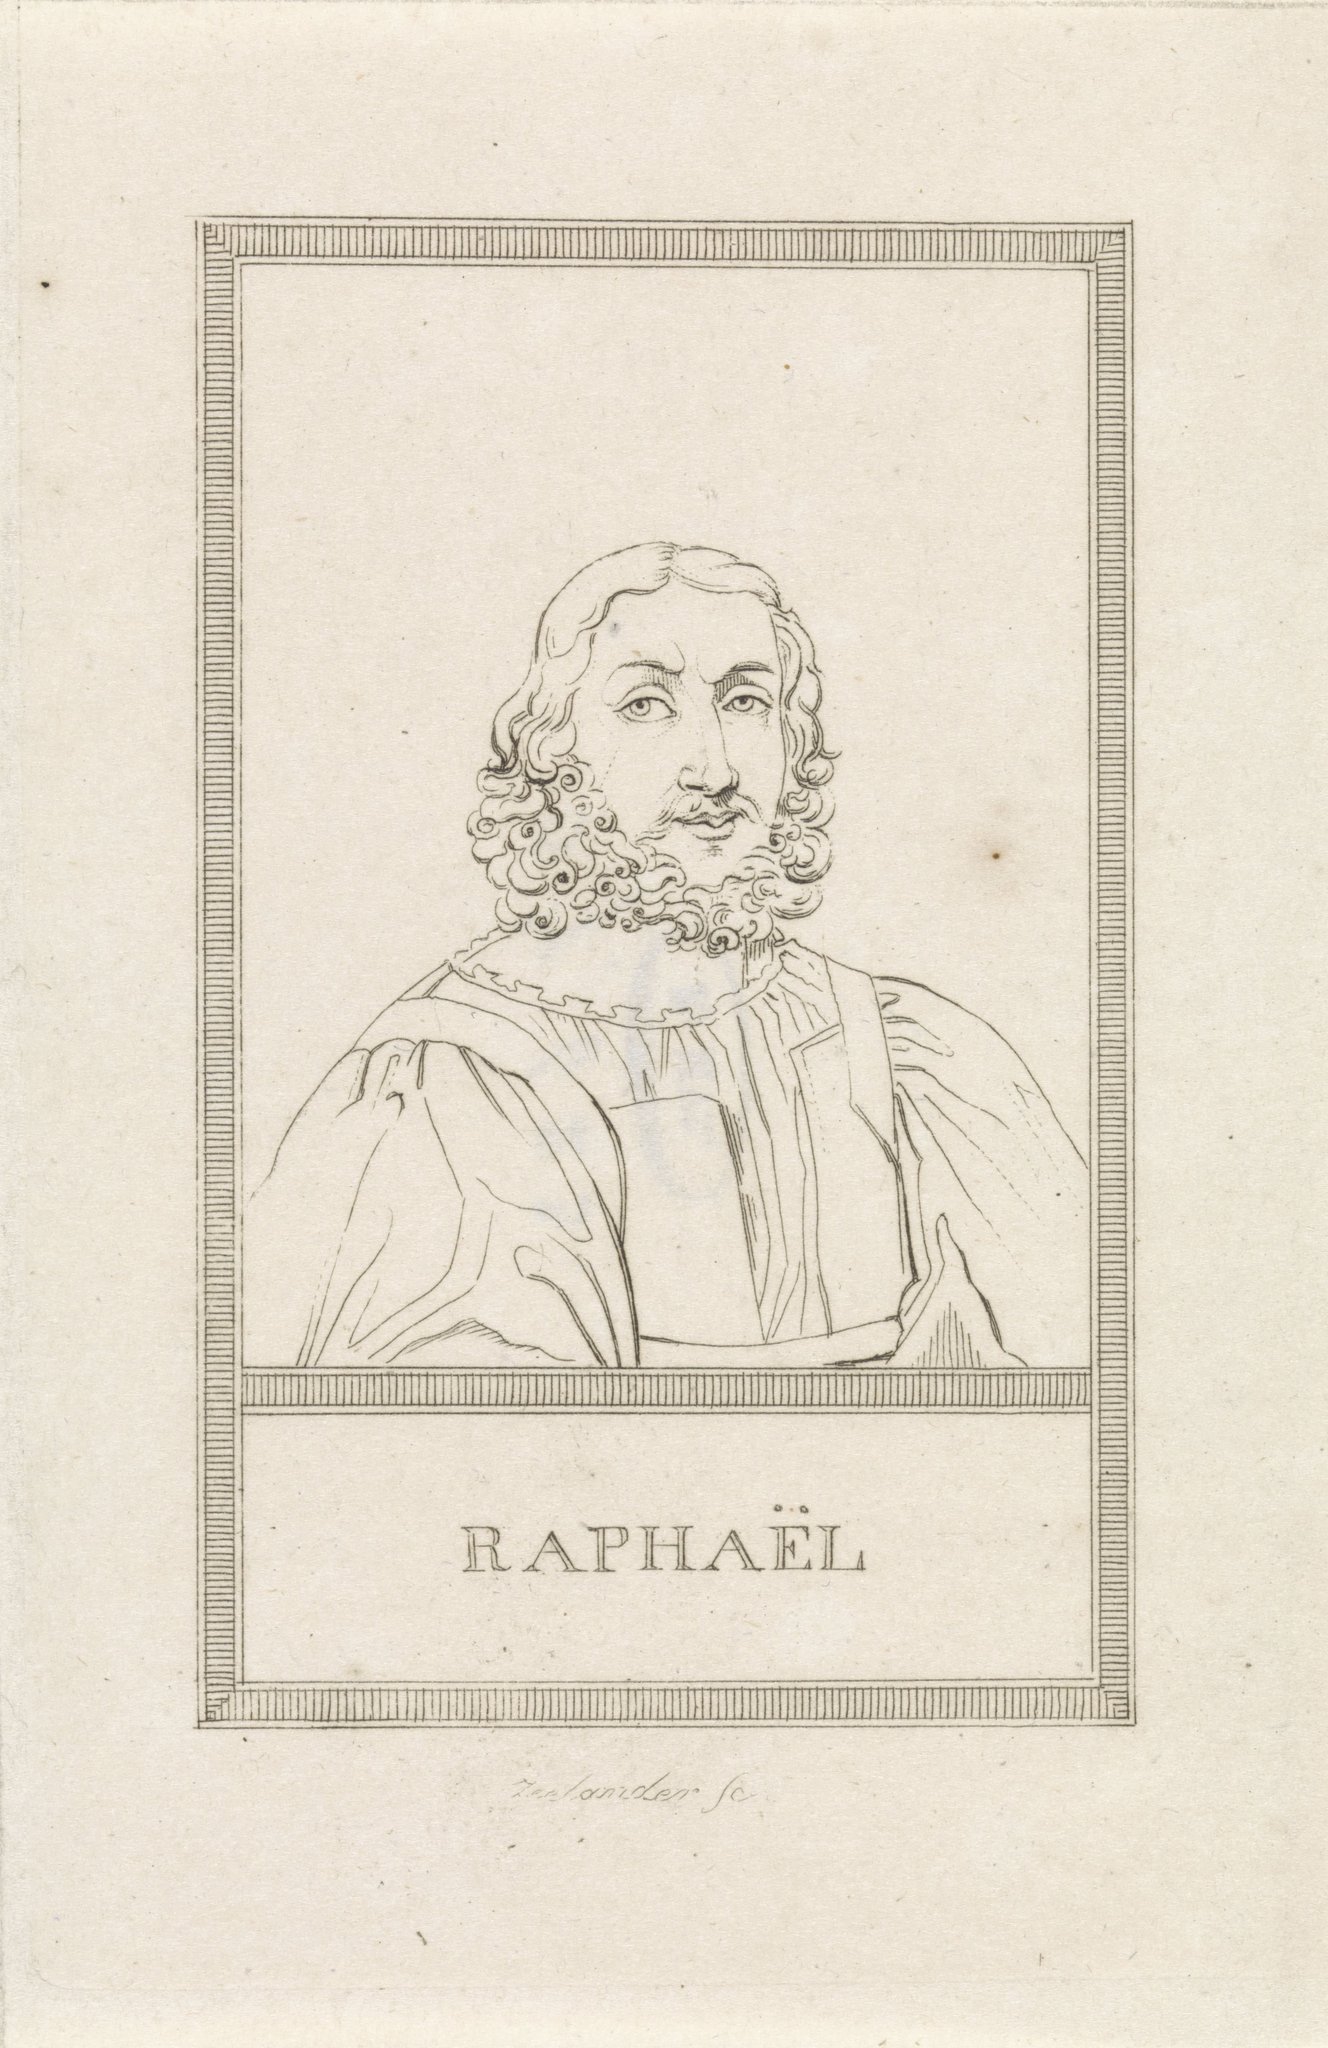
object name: print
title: Portret van kunstenaar Raphael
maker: abraham lion zeelander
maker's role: draughtsman, print maker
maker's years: 1789-1856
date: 1799-1856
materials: paper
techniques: etching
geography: amsterdam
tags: rome, painter, rafaël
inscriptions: collector's mark: Lugt 2228